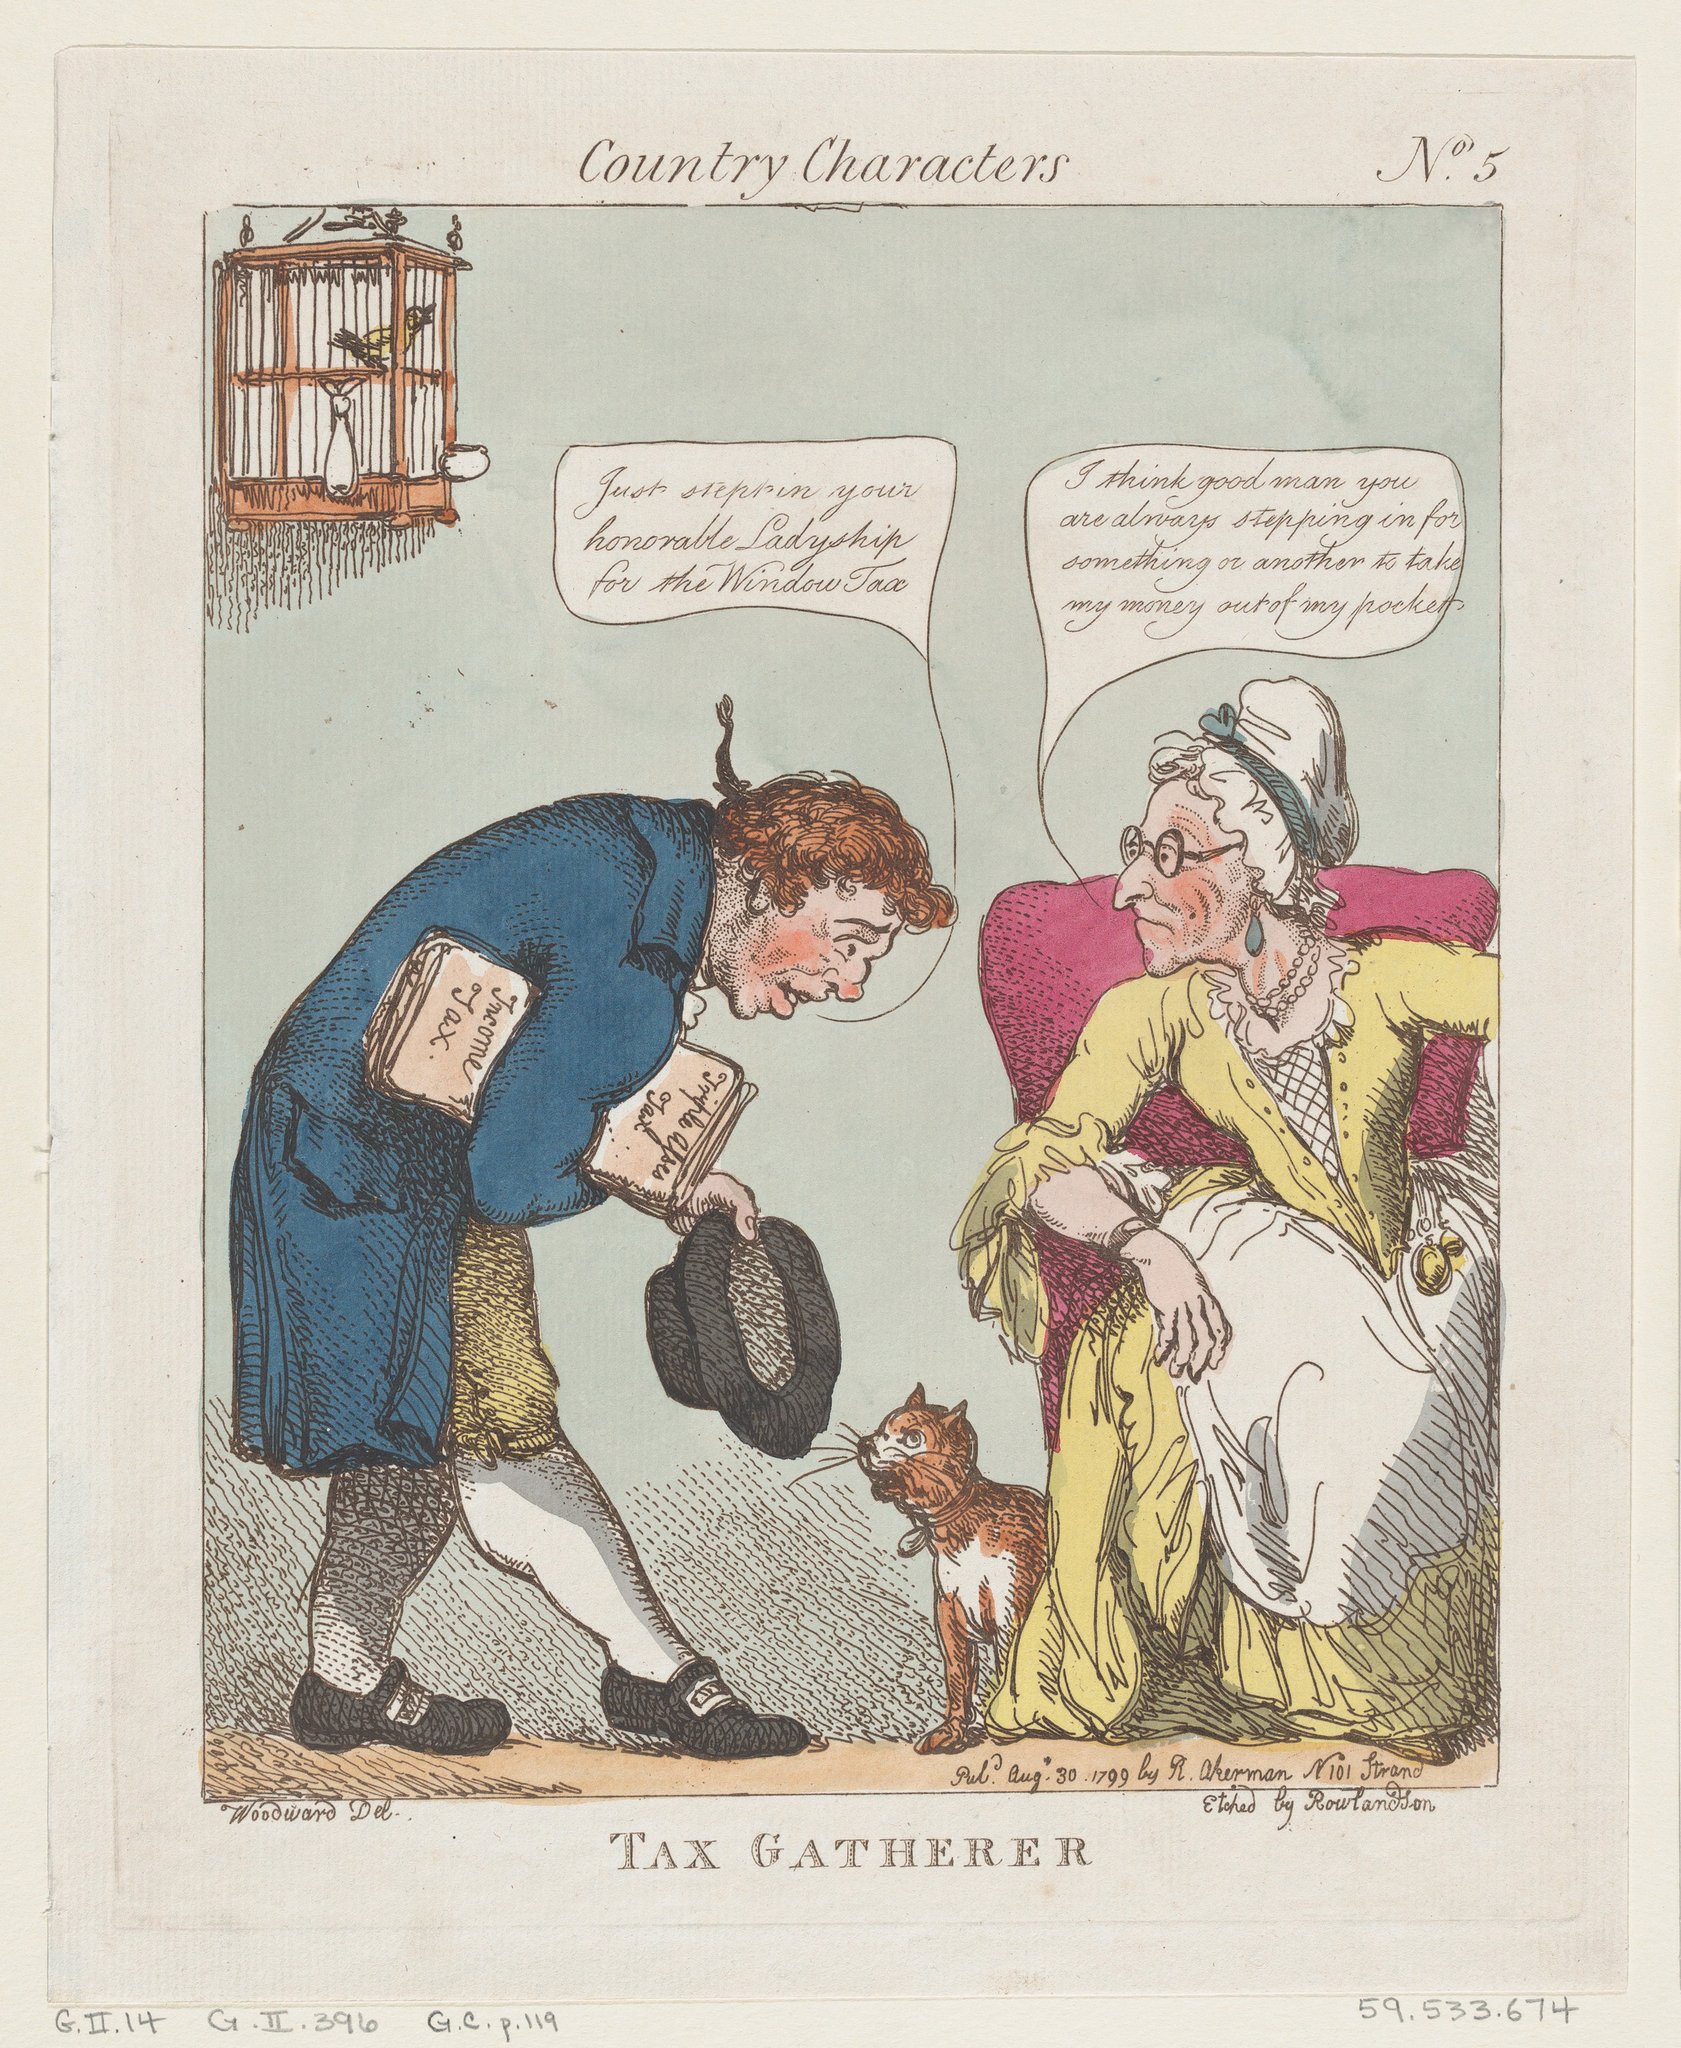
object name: print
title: Tax Gatherer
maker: thomas rowlandson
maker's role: artist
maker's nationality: british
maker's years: 1757-1827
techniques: etching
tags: men,women,cats